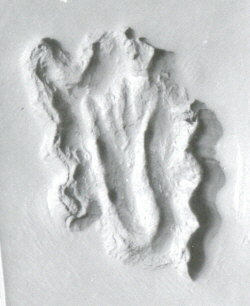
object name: stamp seal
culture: bactria-margiana archaeological complex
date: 2333-1668 BCE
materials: copper alloy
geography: bactria-margiana